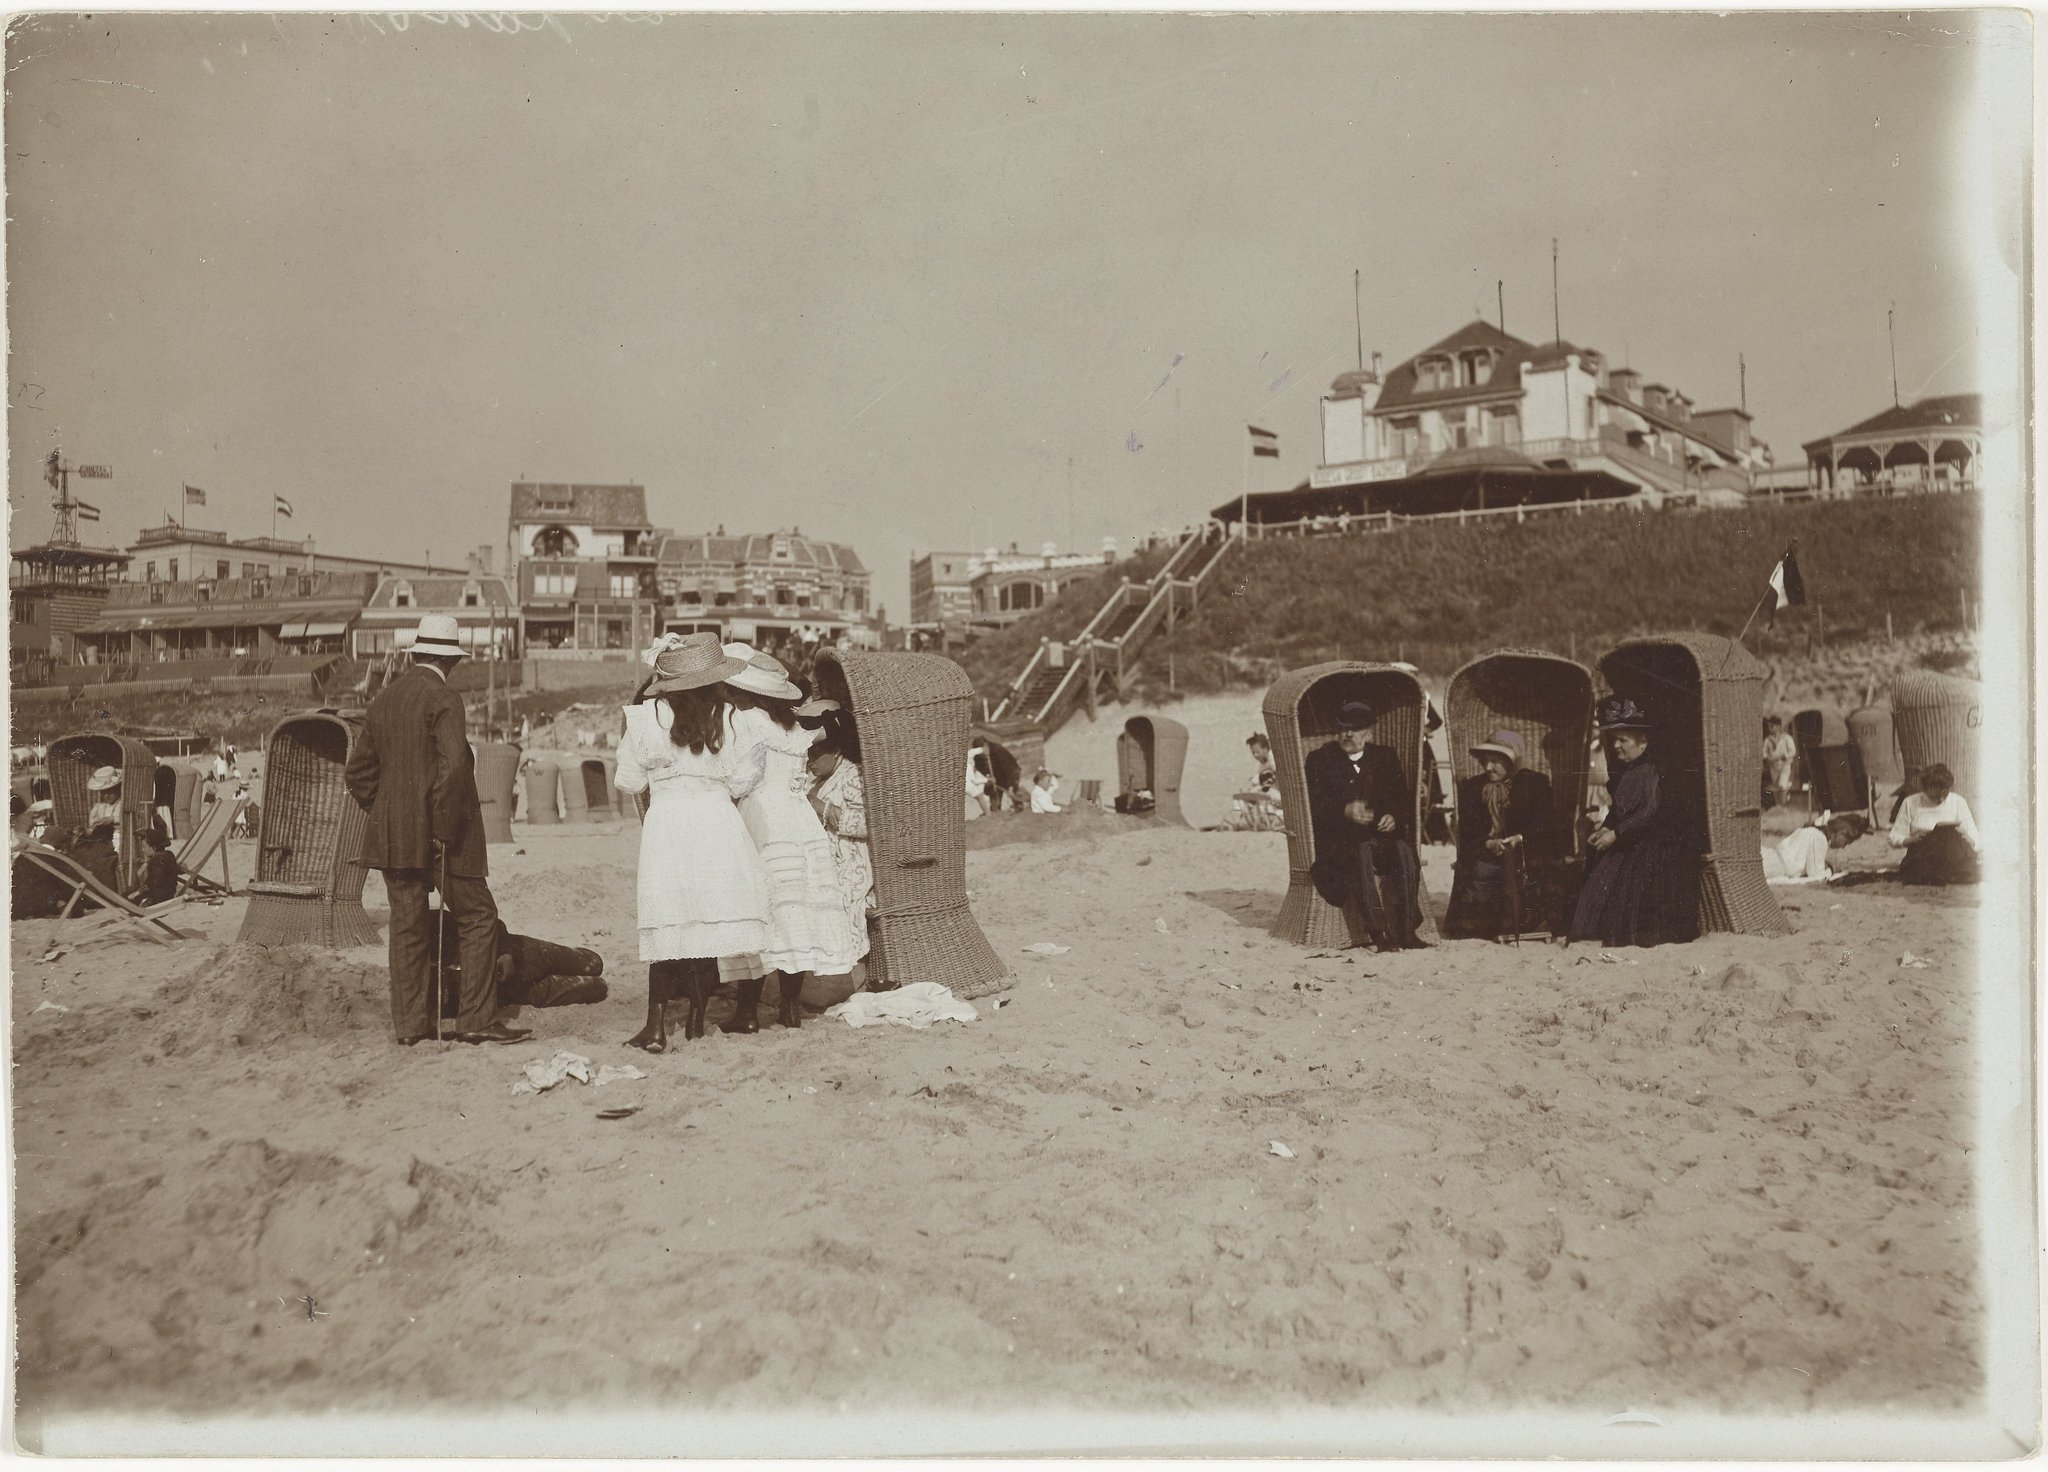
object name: photograph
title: Luieren aan het strand in Zandvoort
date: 1900-1905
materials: photographic support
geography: zandvoort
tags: beach (as place of recreation)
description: Een man en twee vrouwen zitten in strandstoelen. Links wat meisjes in witte jurken en hoedjes op. Op de achtergrond een trap omhoog en gebouwen.